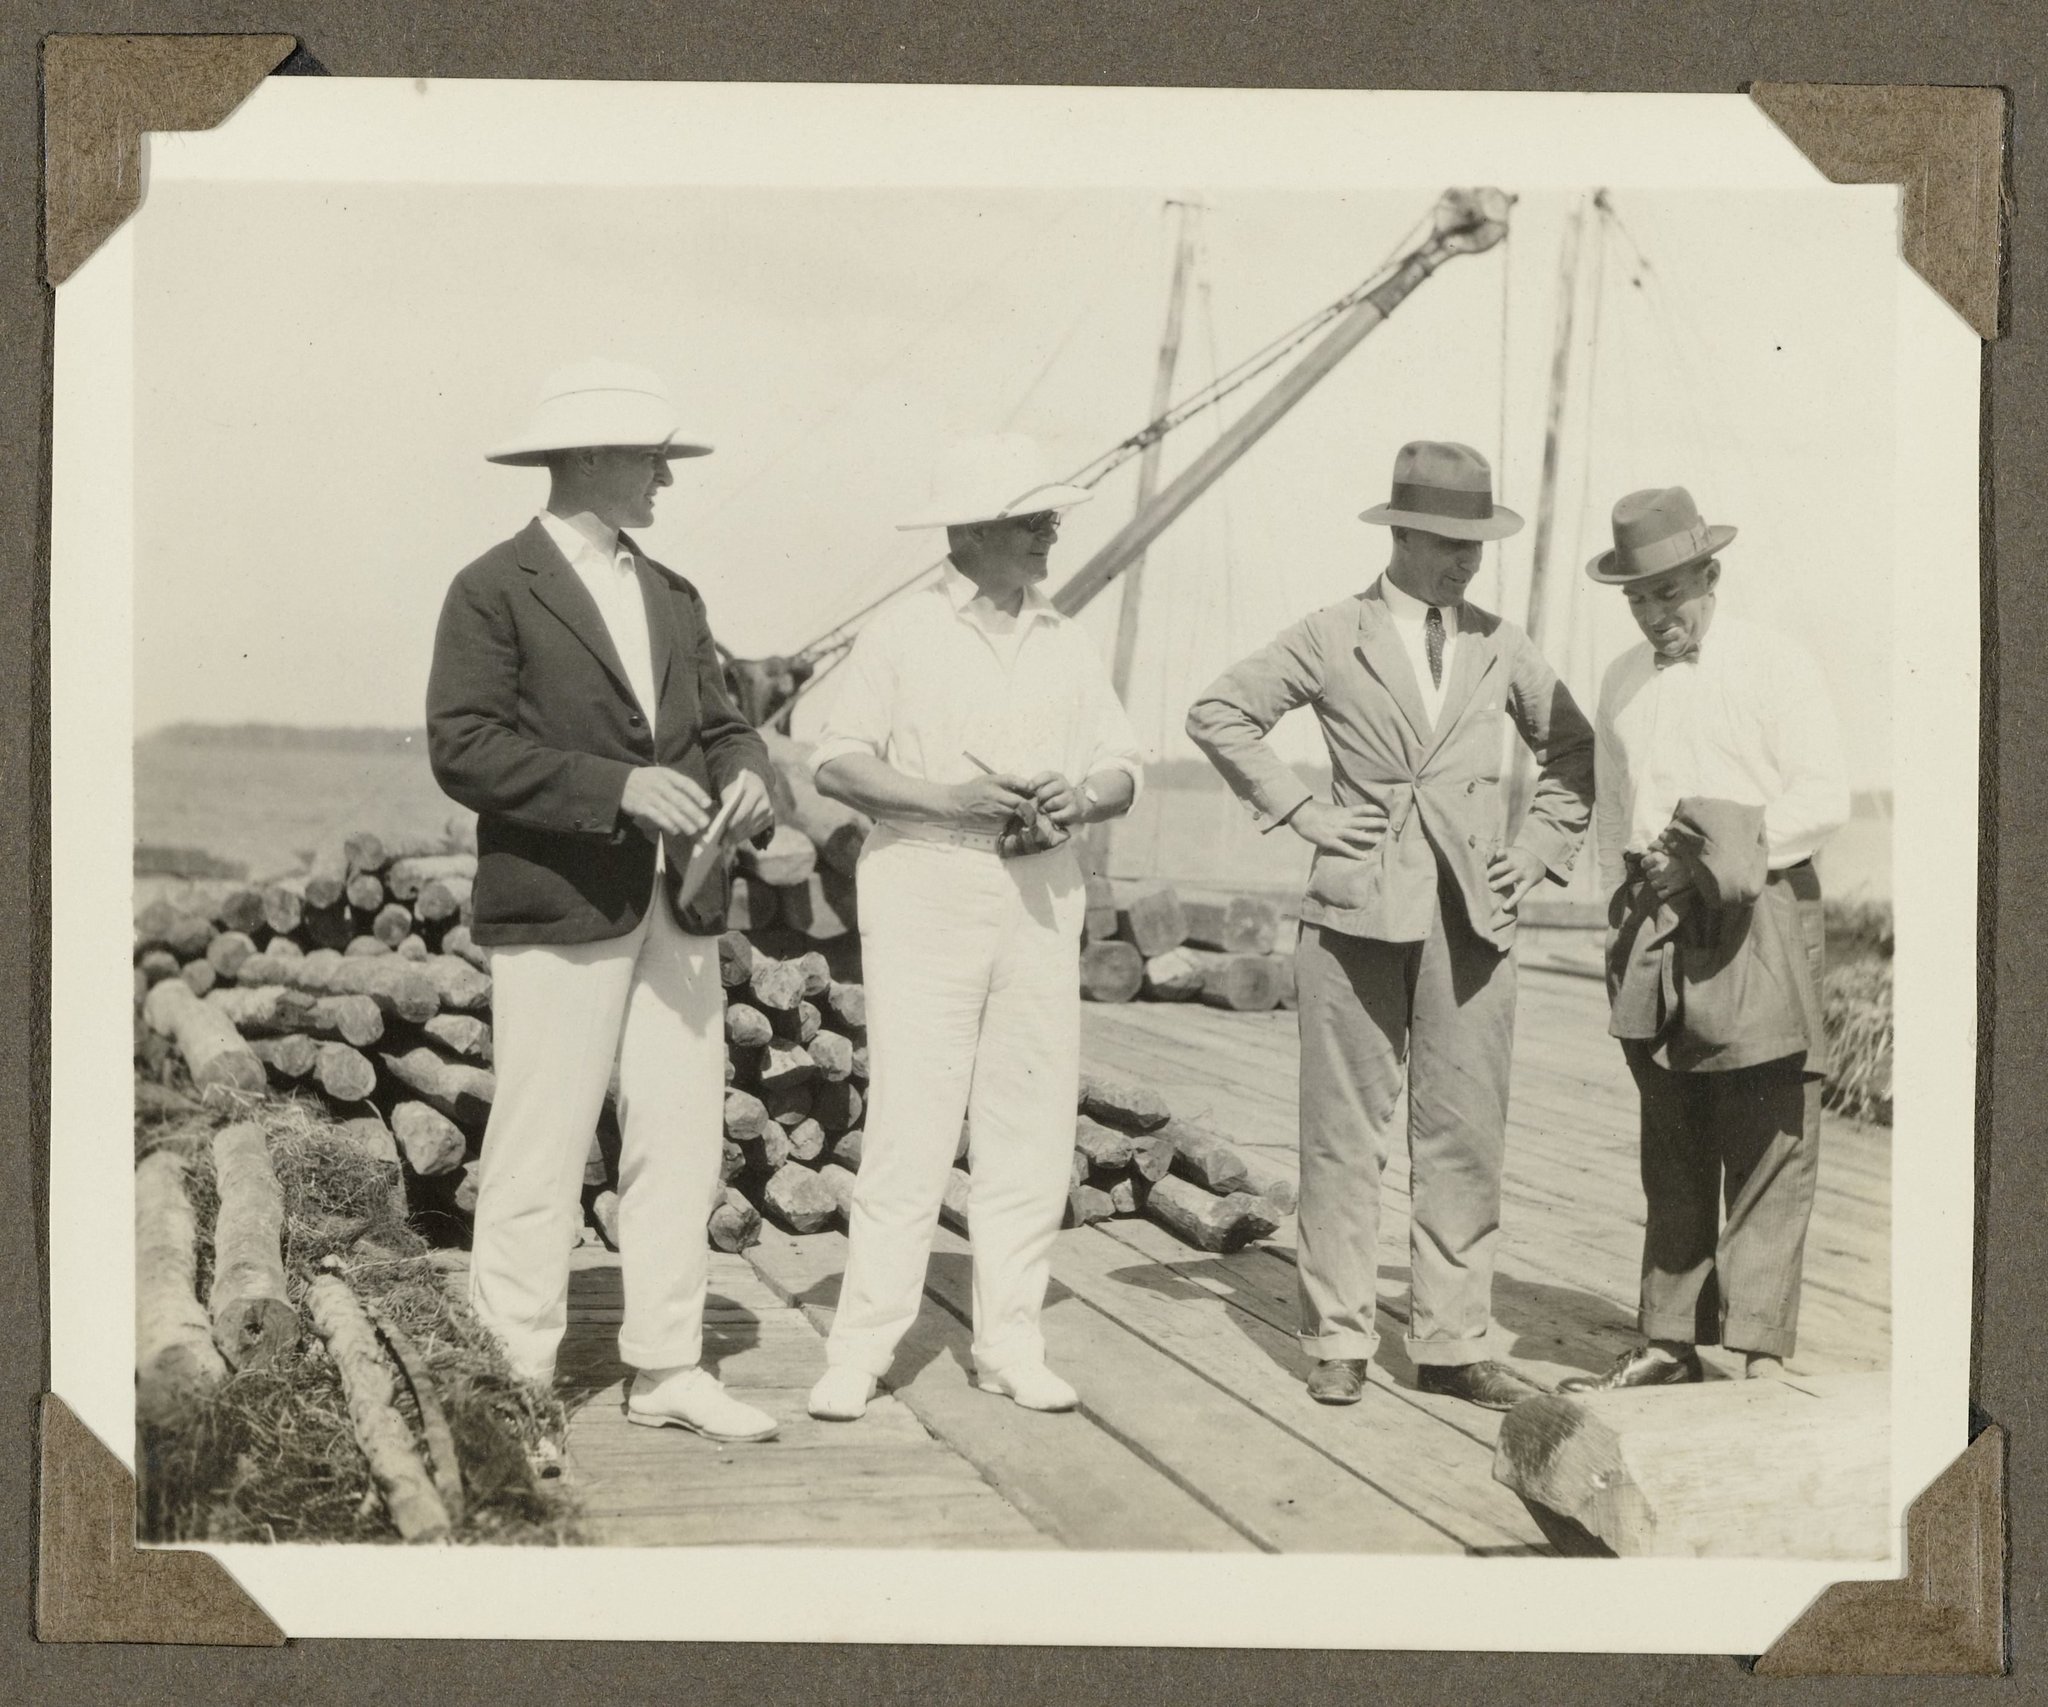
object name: photograph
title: Nederlanders op een steiger in Suriname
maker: Anonymous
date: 1925-1927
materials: photographic support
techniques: photography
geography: suriname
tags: historical persons not known by name, suriname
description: Vier Nederlanders bij bouwwerkzaamheden aan een steiger in Suriname. Foto met hoekjes bevestigd op een bladzijde van een albumblad in het fotoalbum over de familie Jetten en het leven en werken in de mijnstad Moengo in Suriname rond 1927.